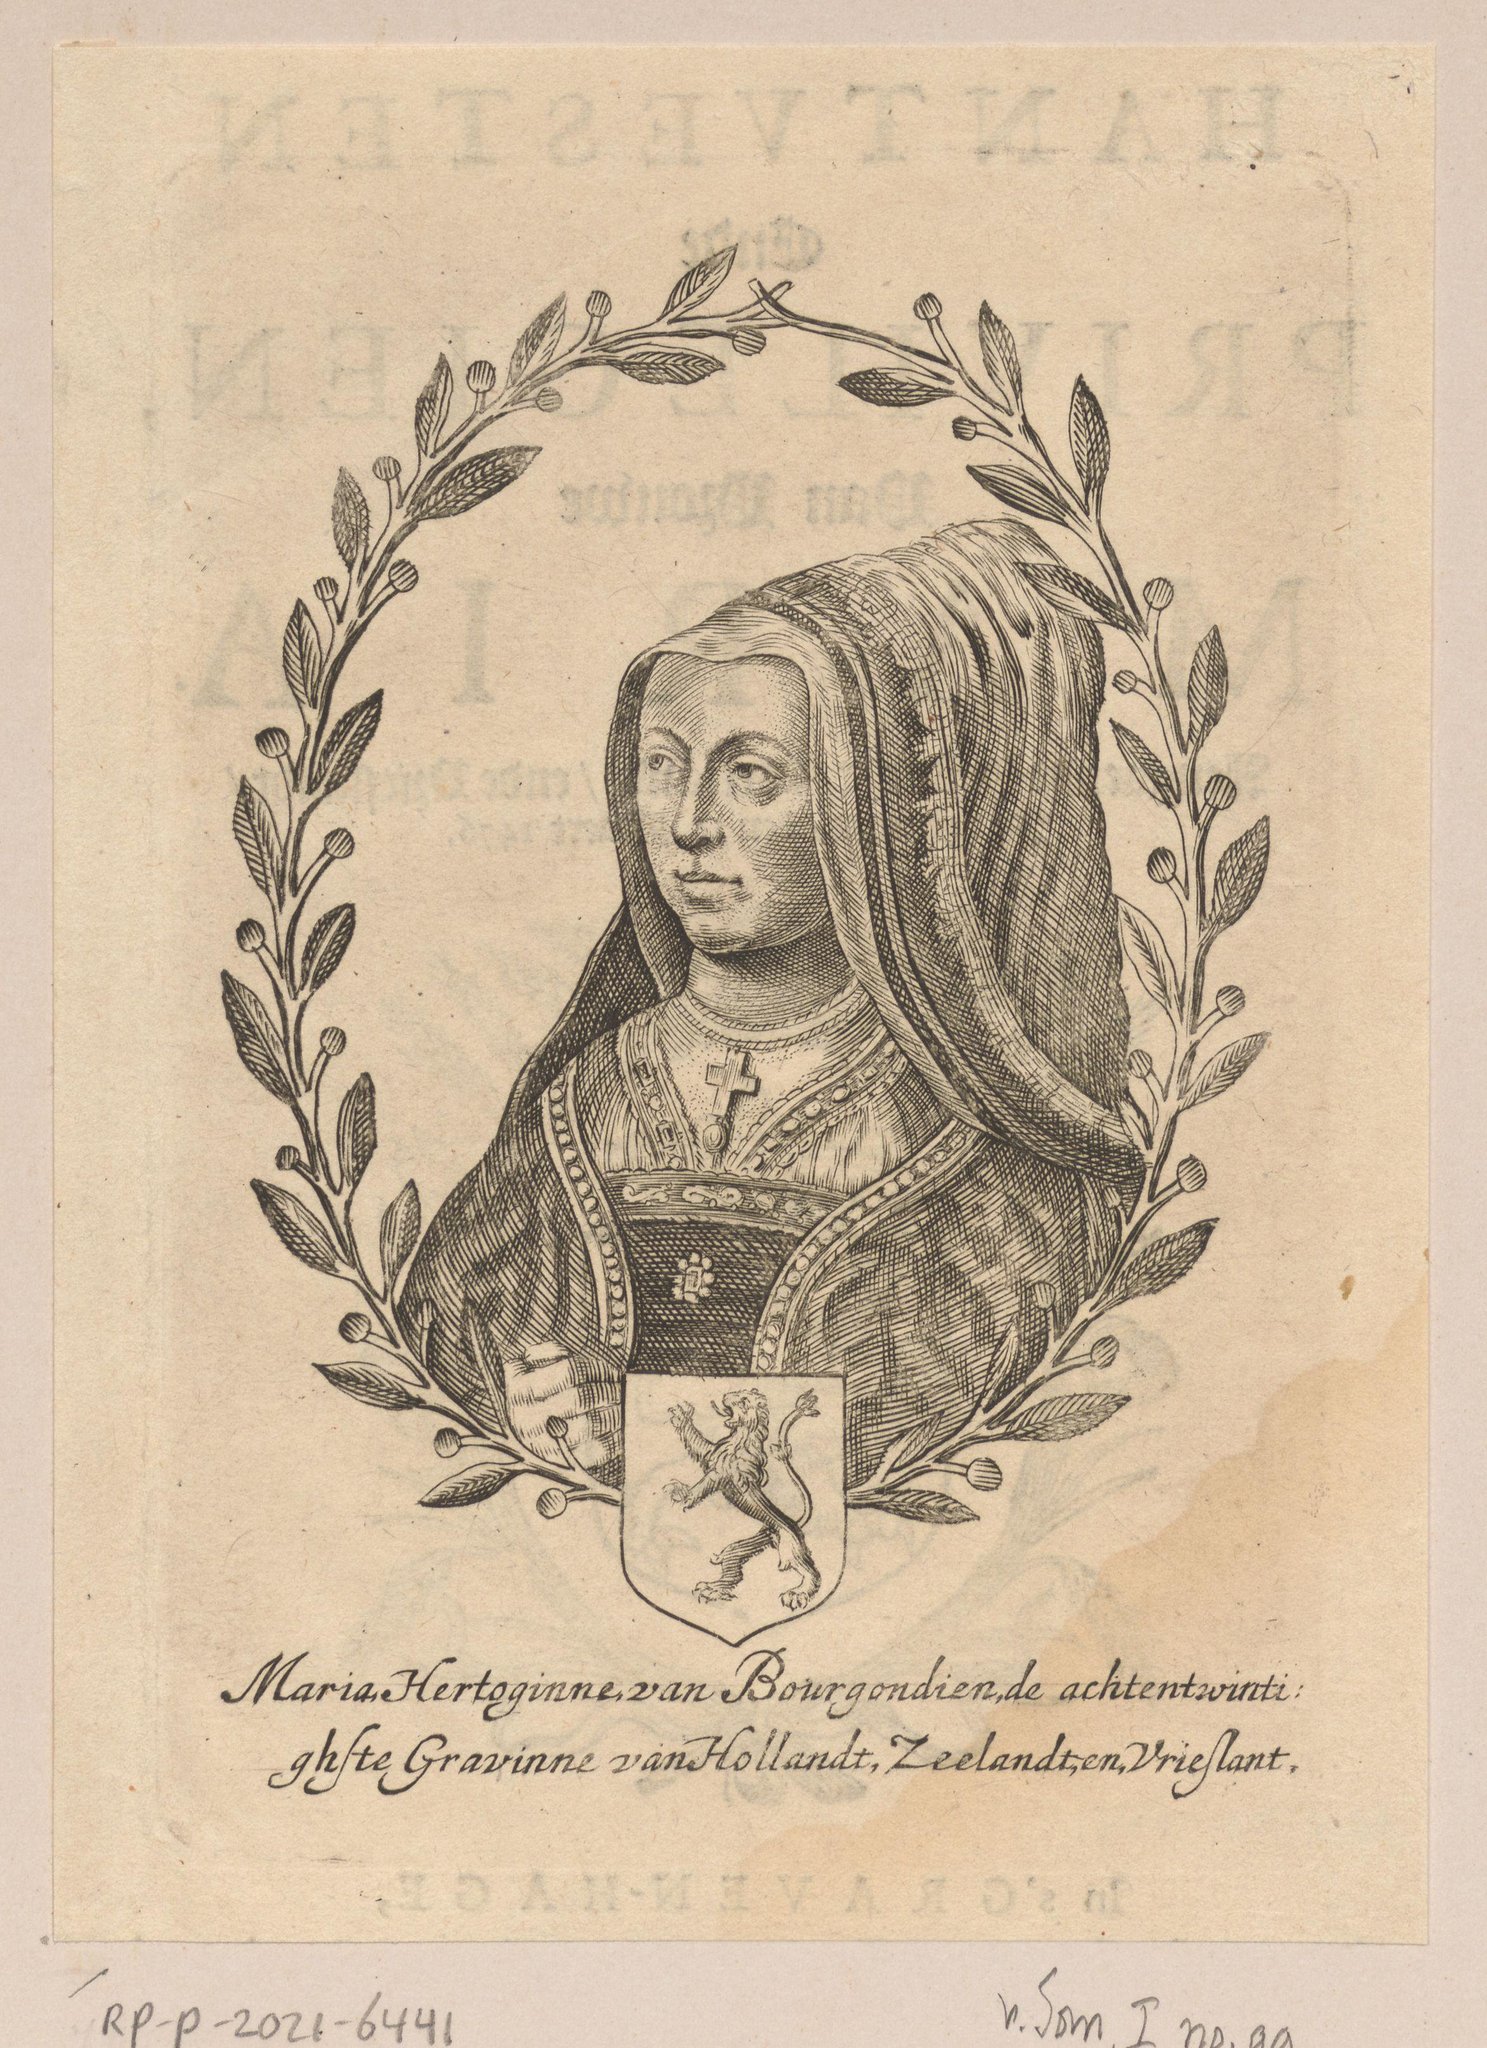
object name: print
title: Portret van Maria van Bourgondië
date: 1663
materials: paper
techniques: engraving, letterpress printing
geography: the hague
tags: brussels, bruges, maria (hertogin van bourgondië), historical persons - bb - woman, armorial bearing, heraldry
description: Verso is de titelpagina van: Handvesten ende privilegiën van Vrouwe Maria (...). Den Haag: Johannes Tongerloo, 1663.